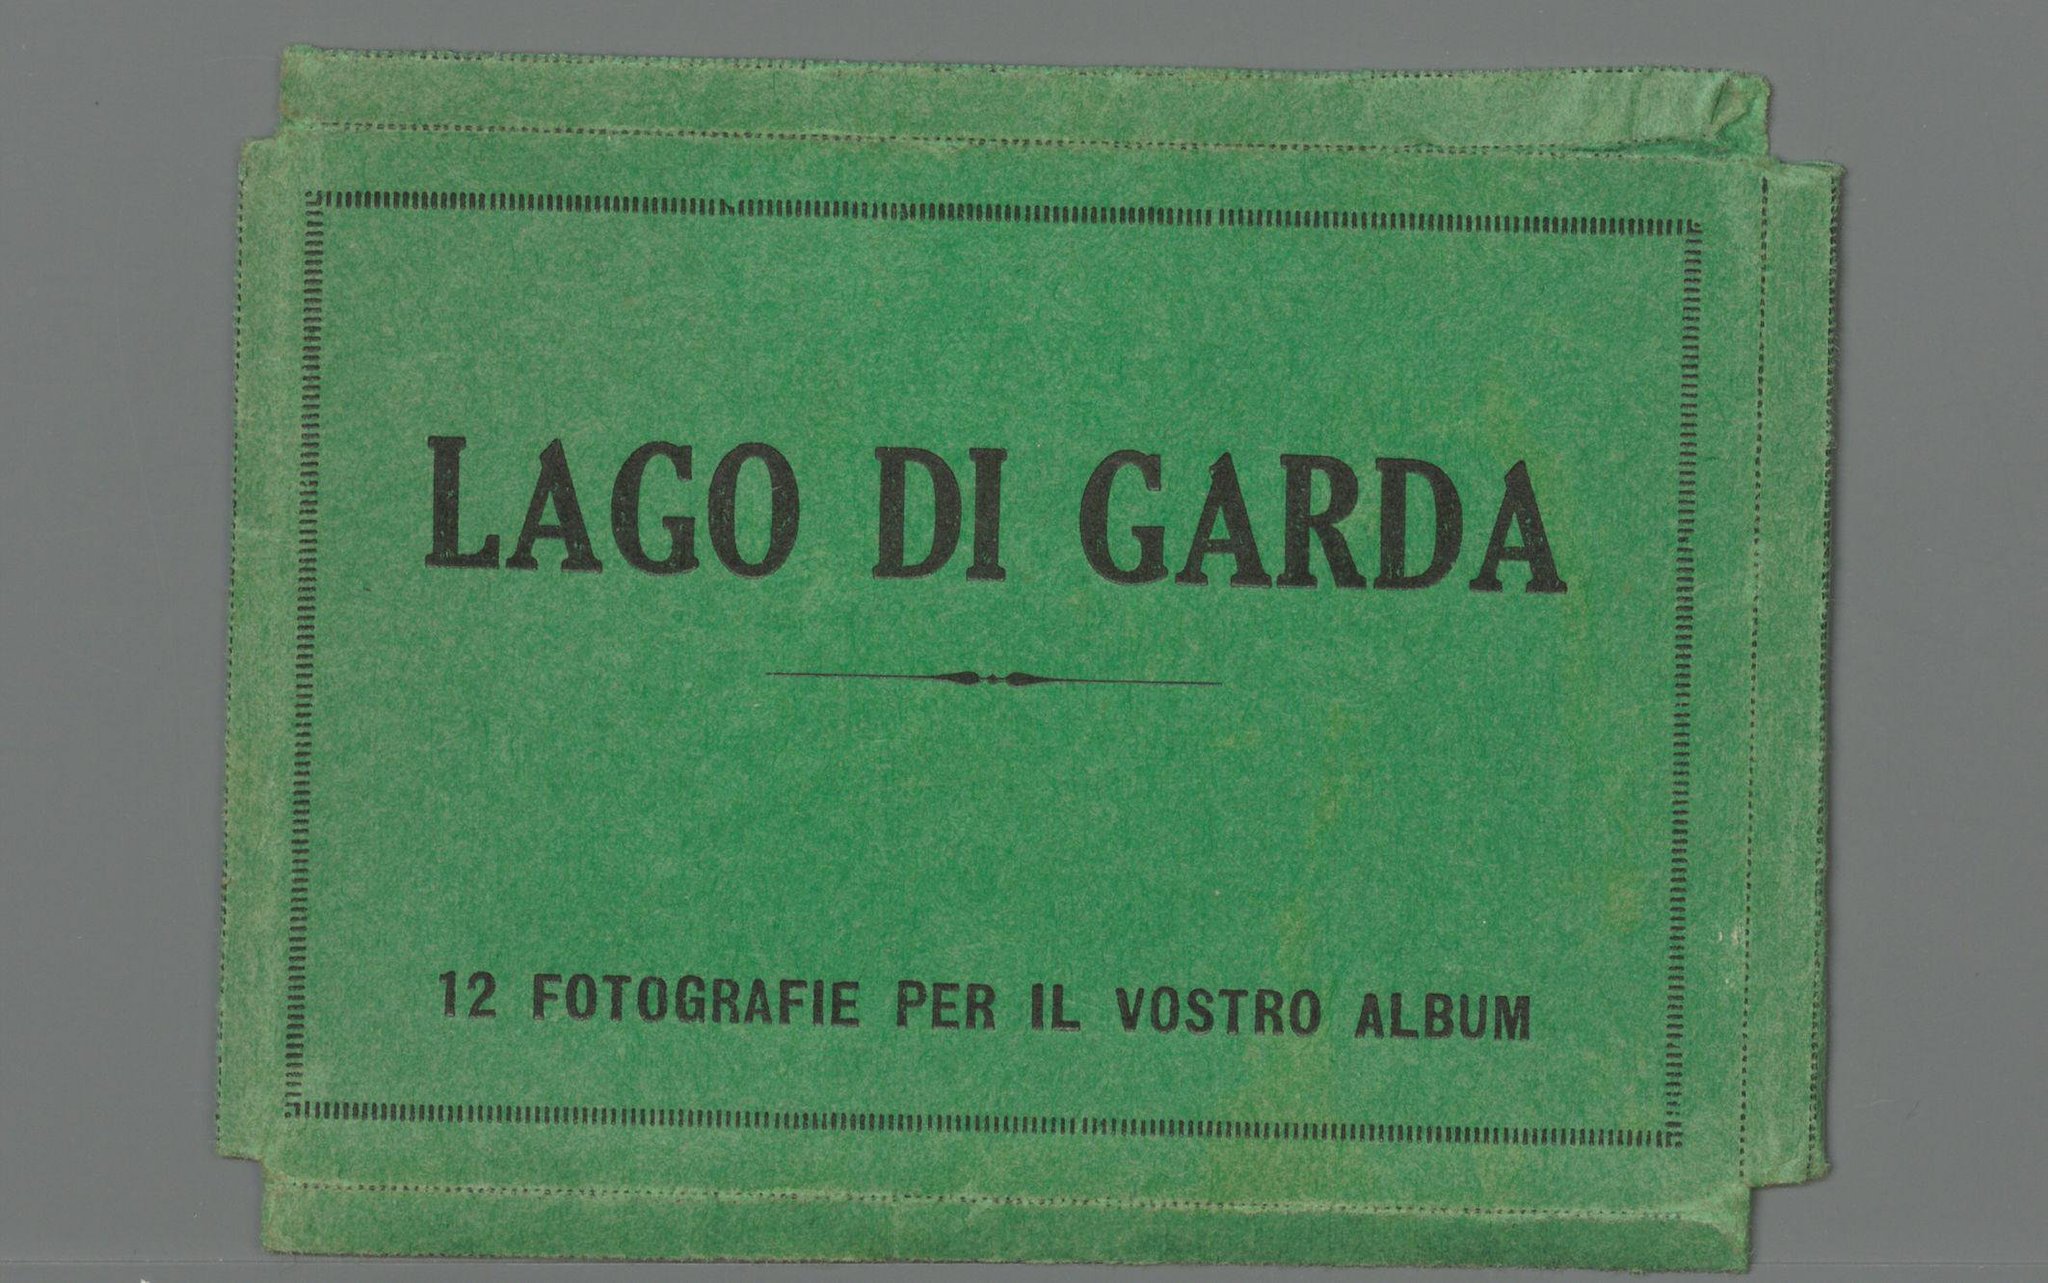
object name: wrapper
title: Omslag voor negen toeristische foto's van het Gardameer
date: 1925-1935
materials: cardboard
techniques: letterpress printing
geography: riva del garda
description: Het omslag is bedoeld voor twaalf foto's. In dit exemplaar zijn negen foto's aangetroffen.